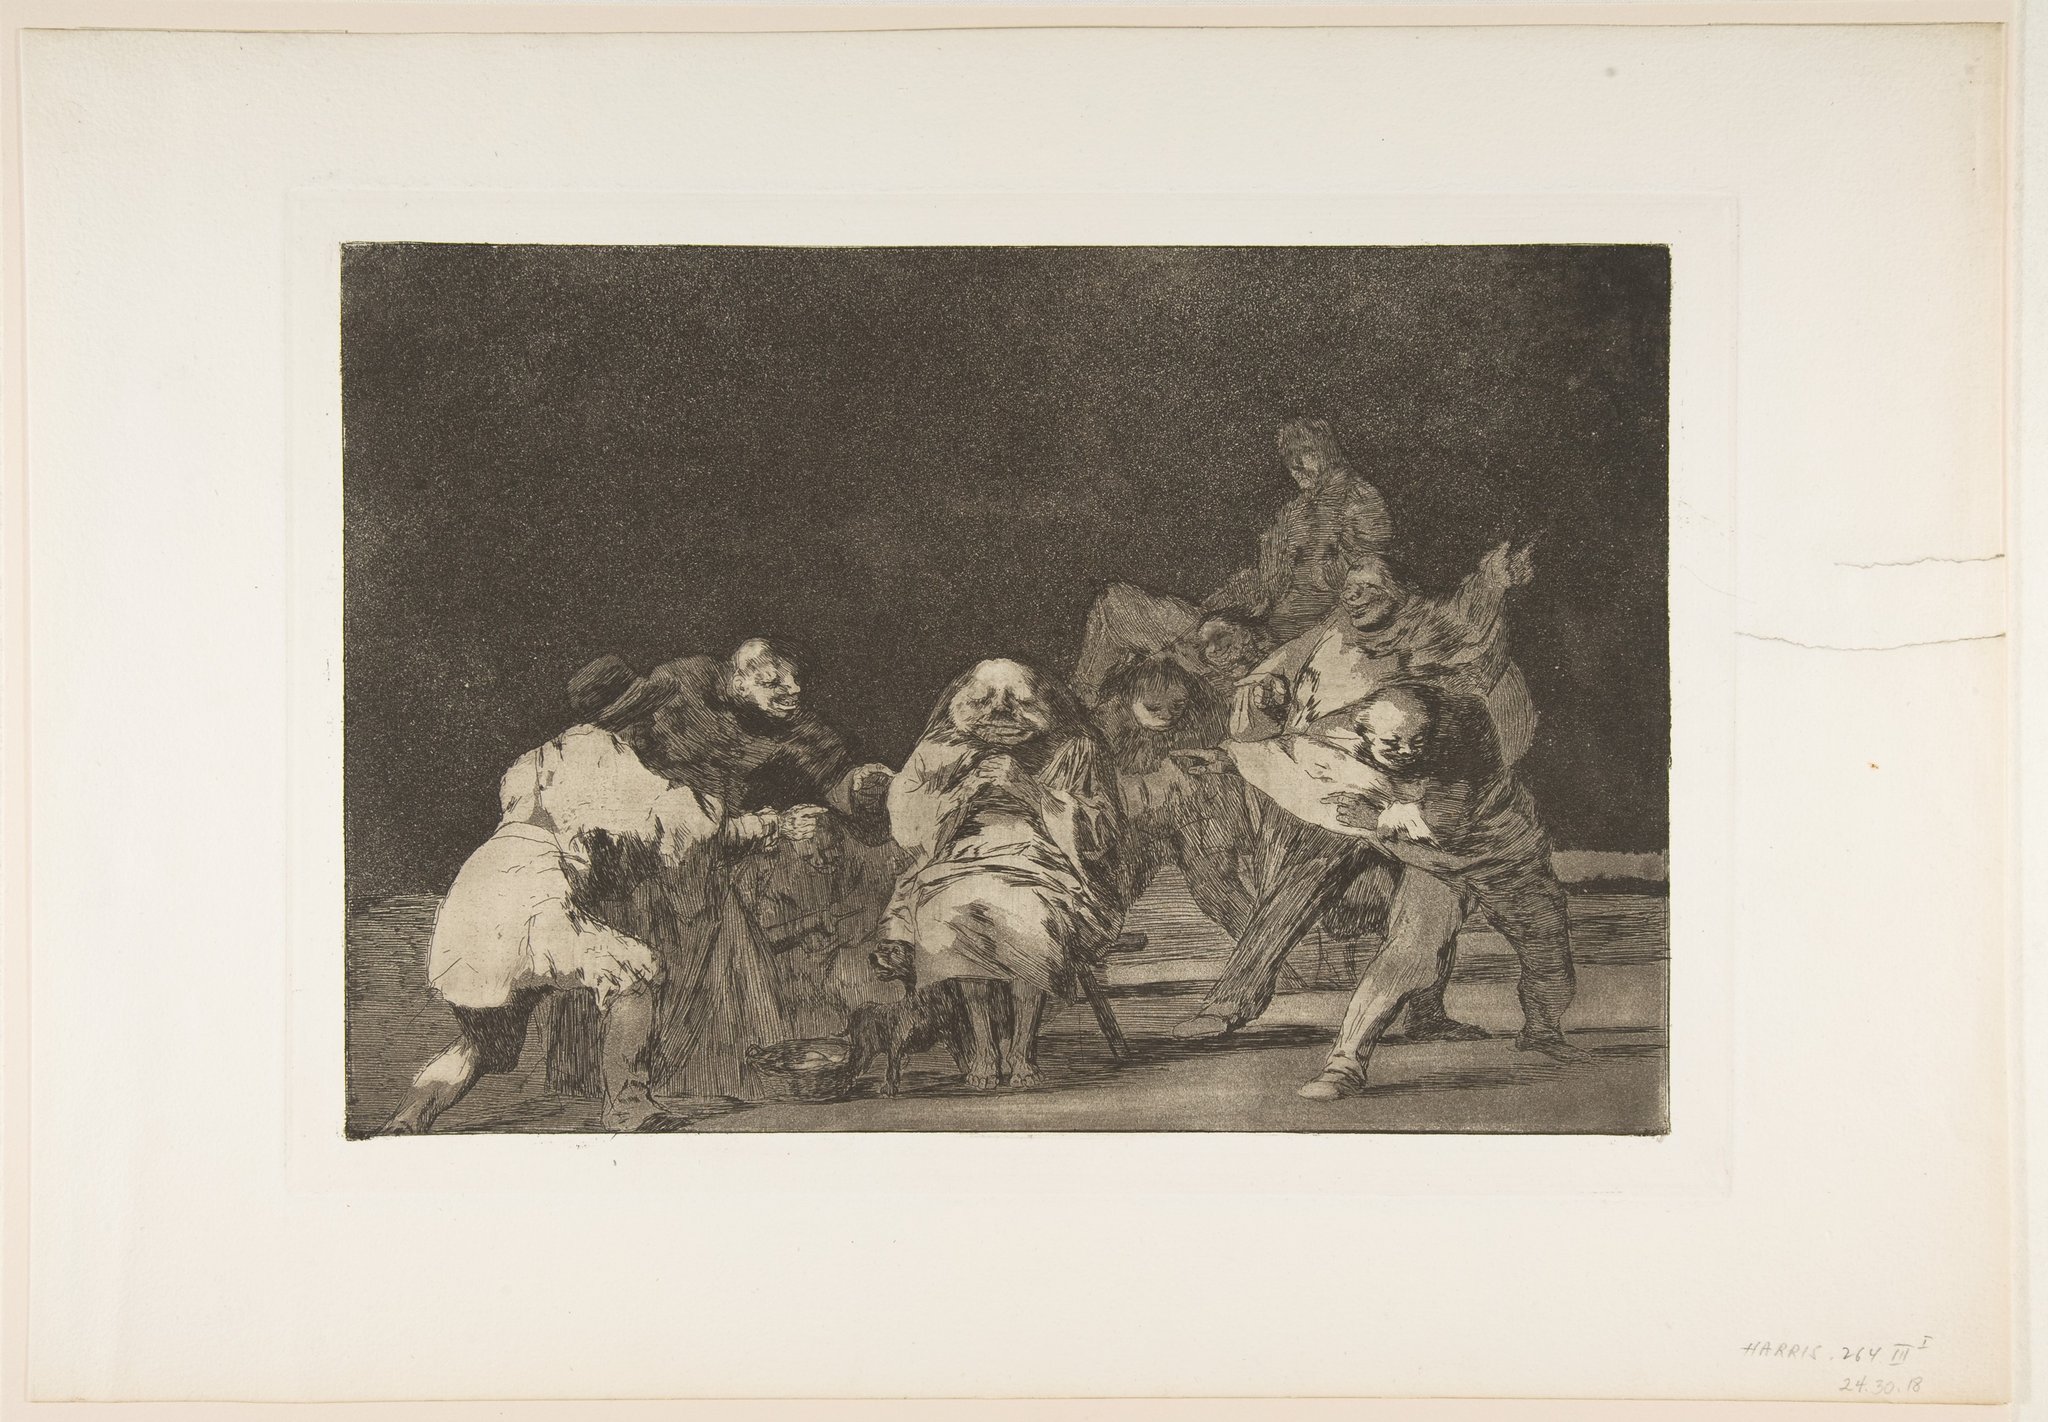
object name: print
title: Loyalty, from "The Disparates" (Follies / Irrationalities)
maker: goya (francisco de goya y lucientes)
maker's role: artist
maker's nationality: spanish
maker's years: 1746-1828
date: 1815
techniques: aquatint, burnishing, etching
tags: men